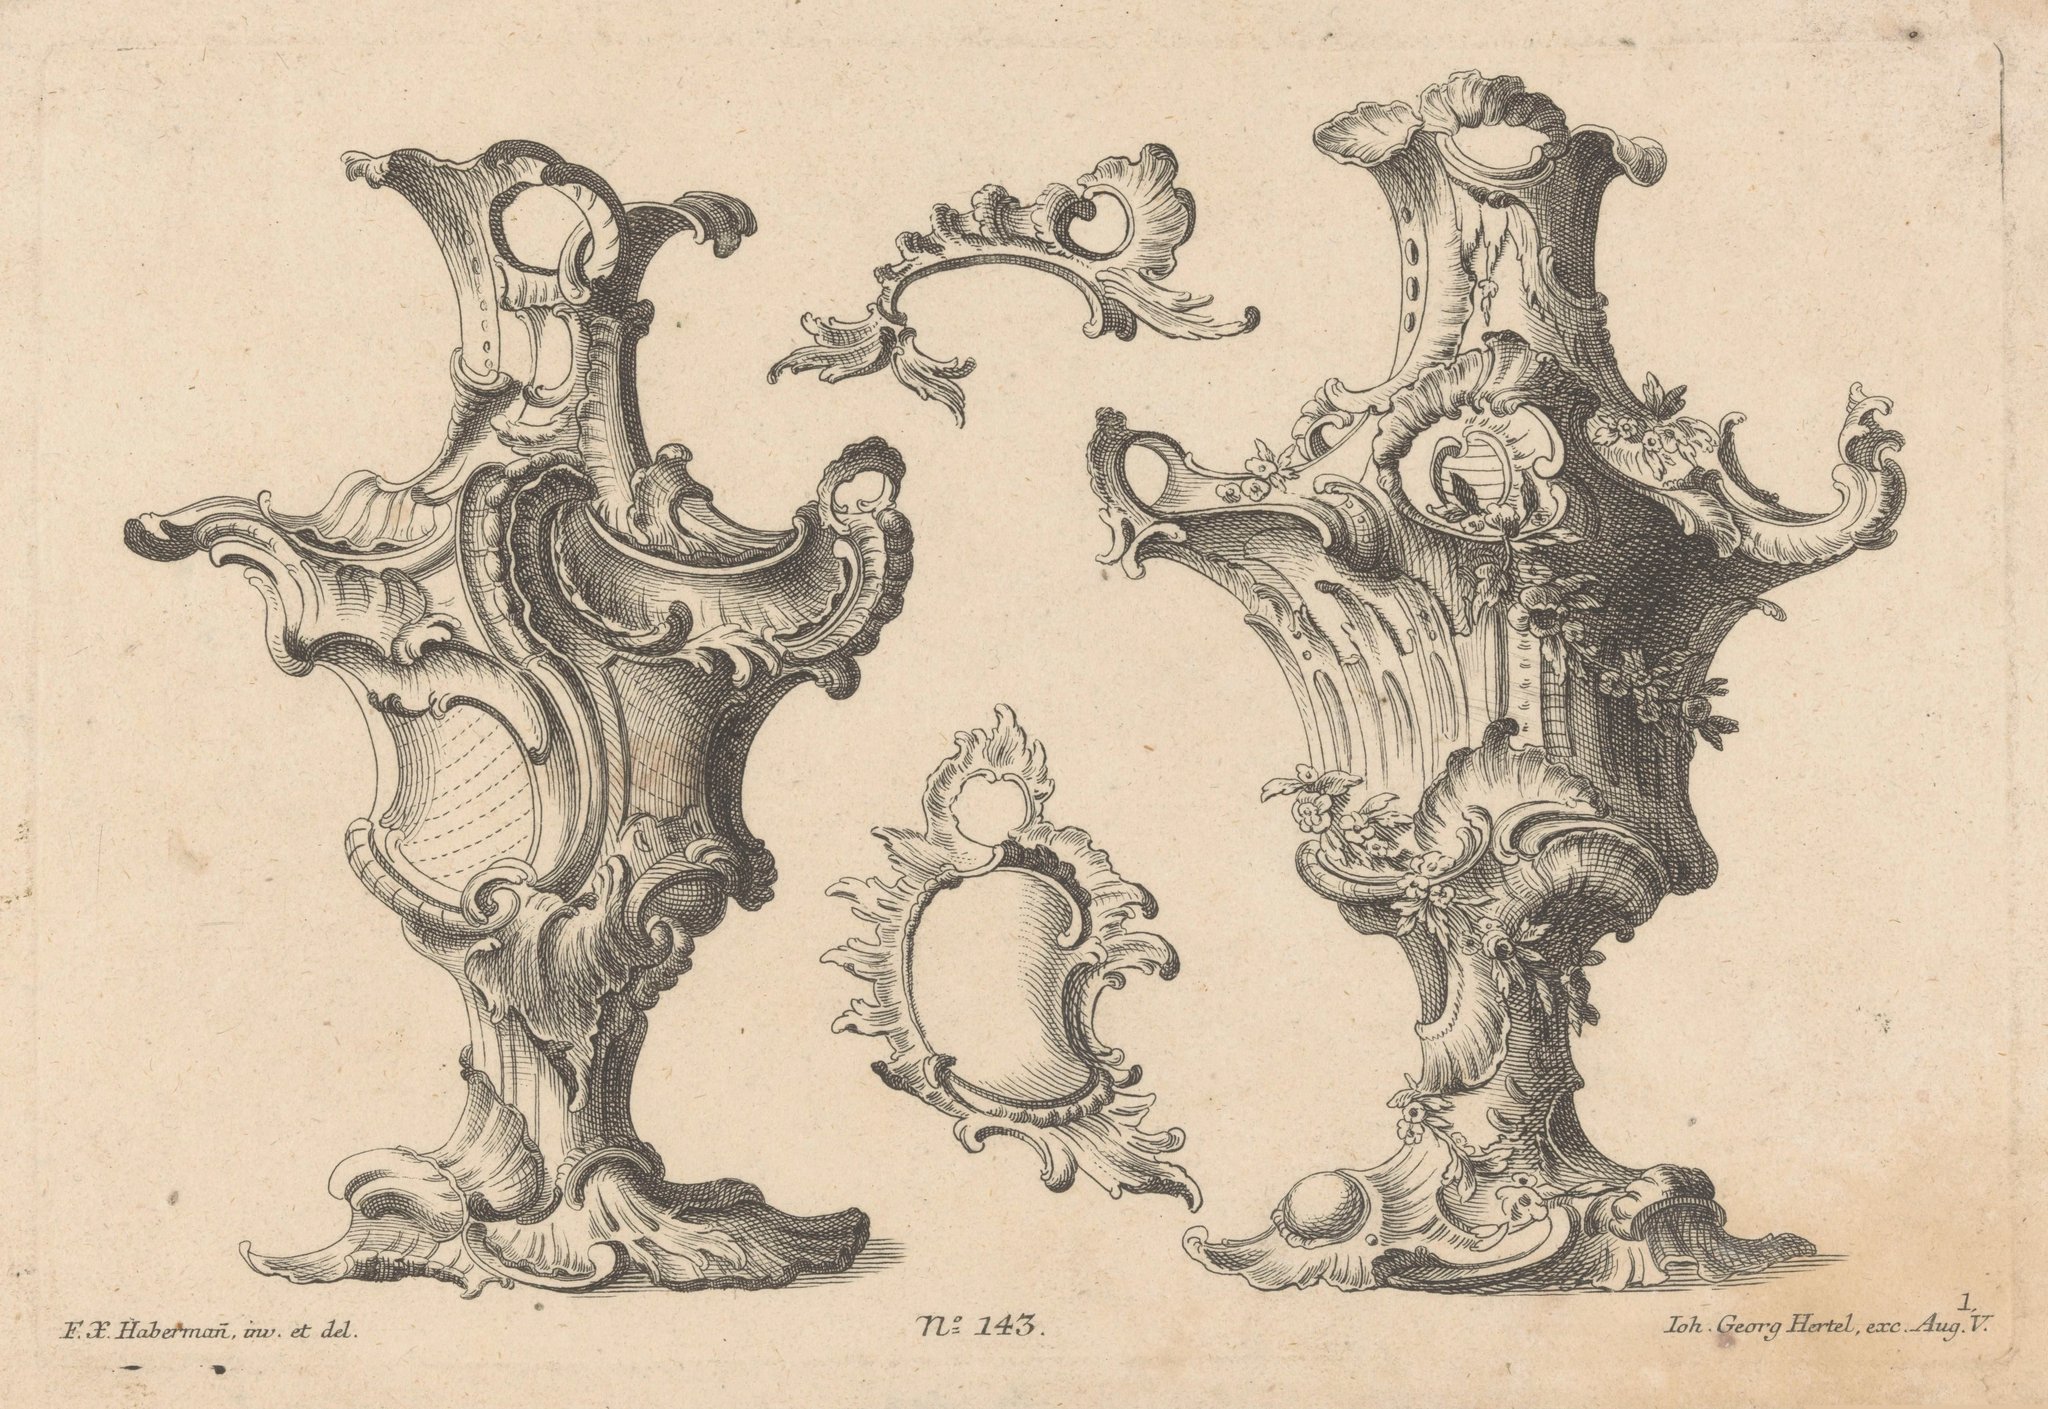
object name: ornament print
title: Twee vazen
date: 1731-1775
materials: paper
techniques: etching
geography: augsburg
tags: rocaille ornament, vase ~ ornament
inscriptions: watermark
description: Twee siervazen met rocaille ornamenten en bloemmotieven. Uitgeversnummer 143.